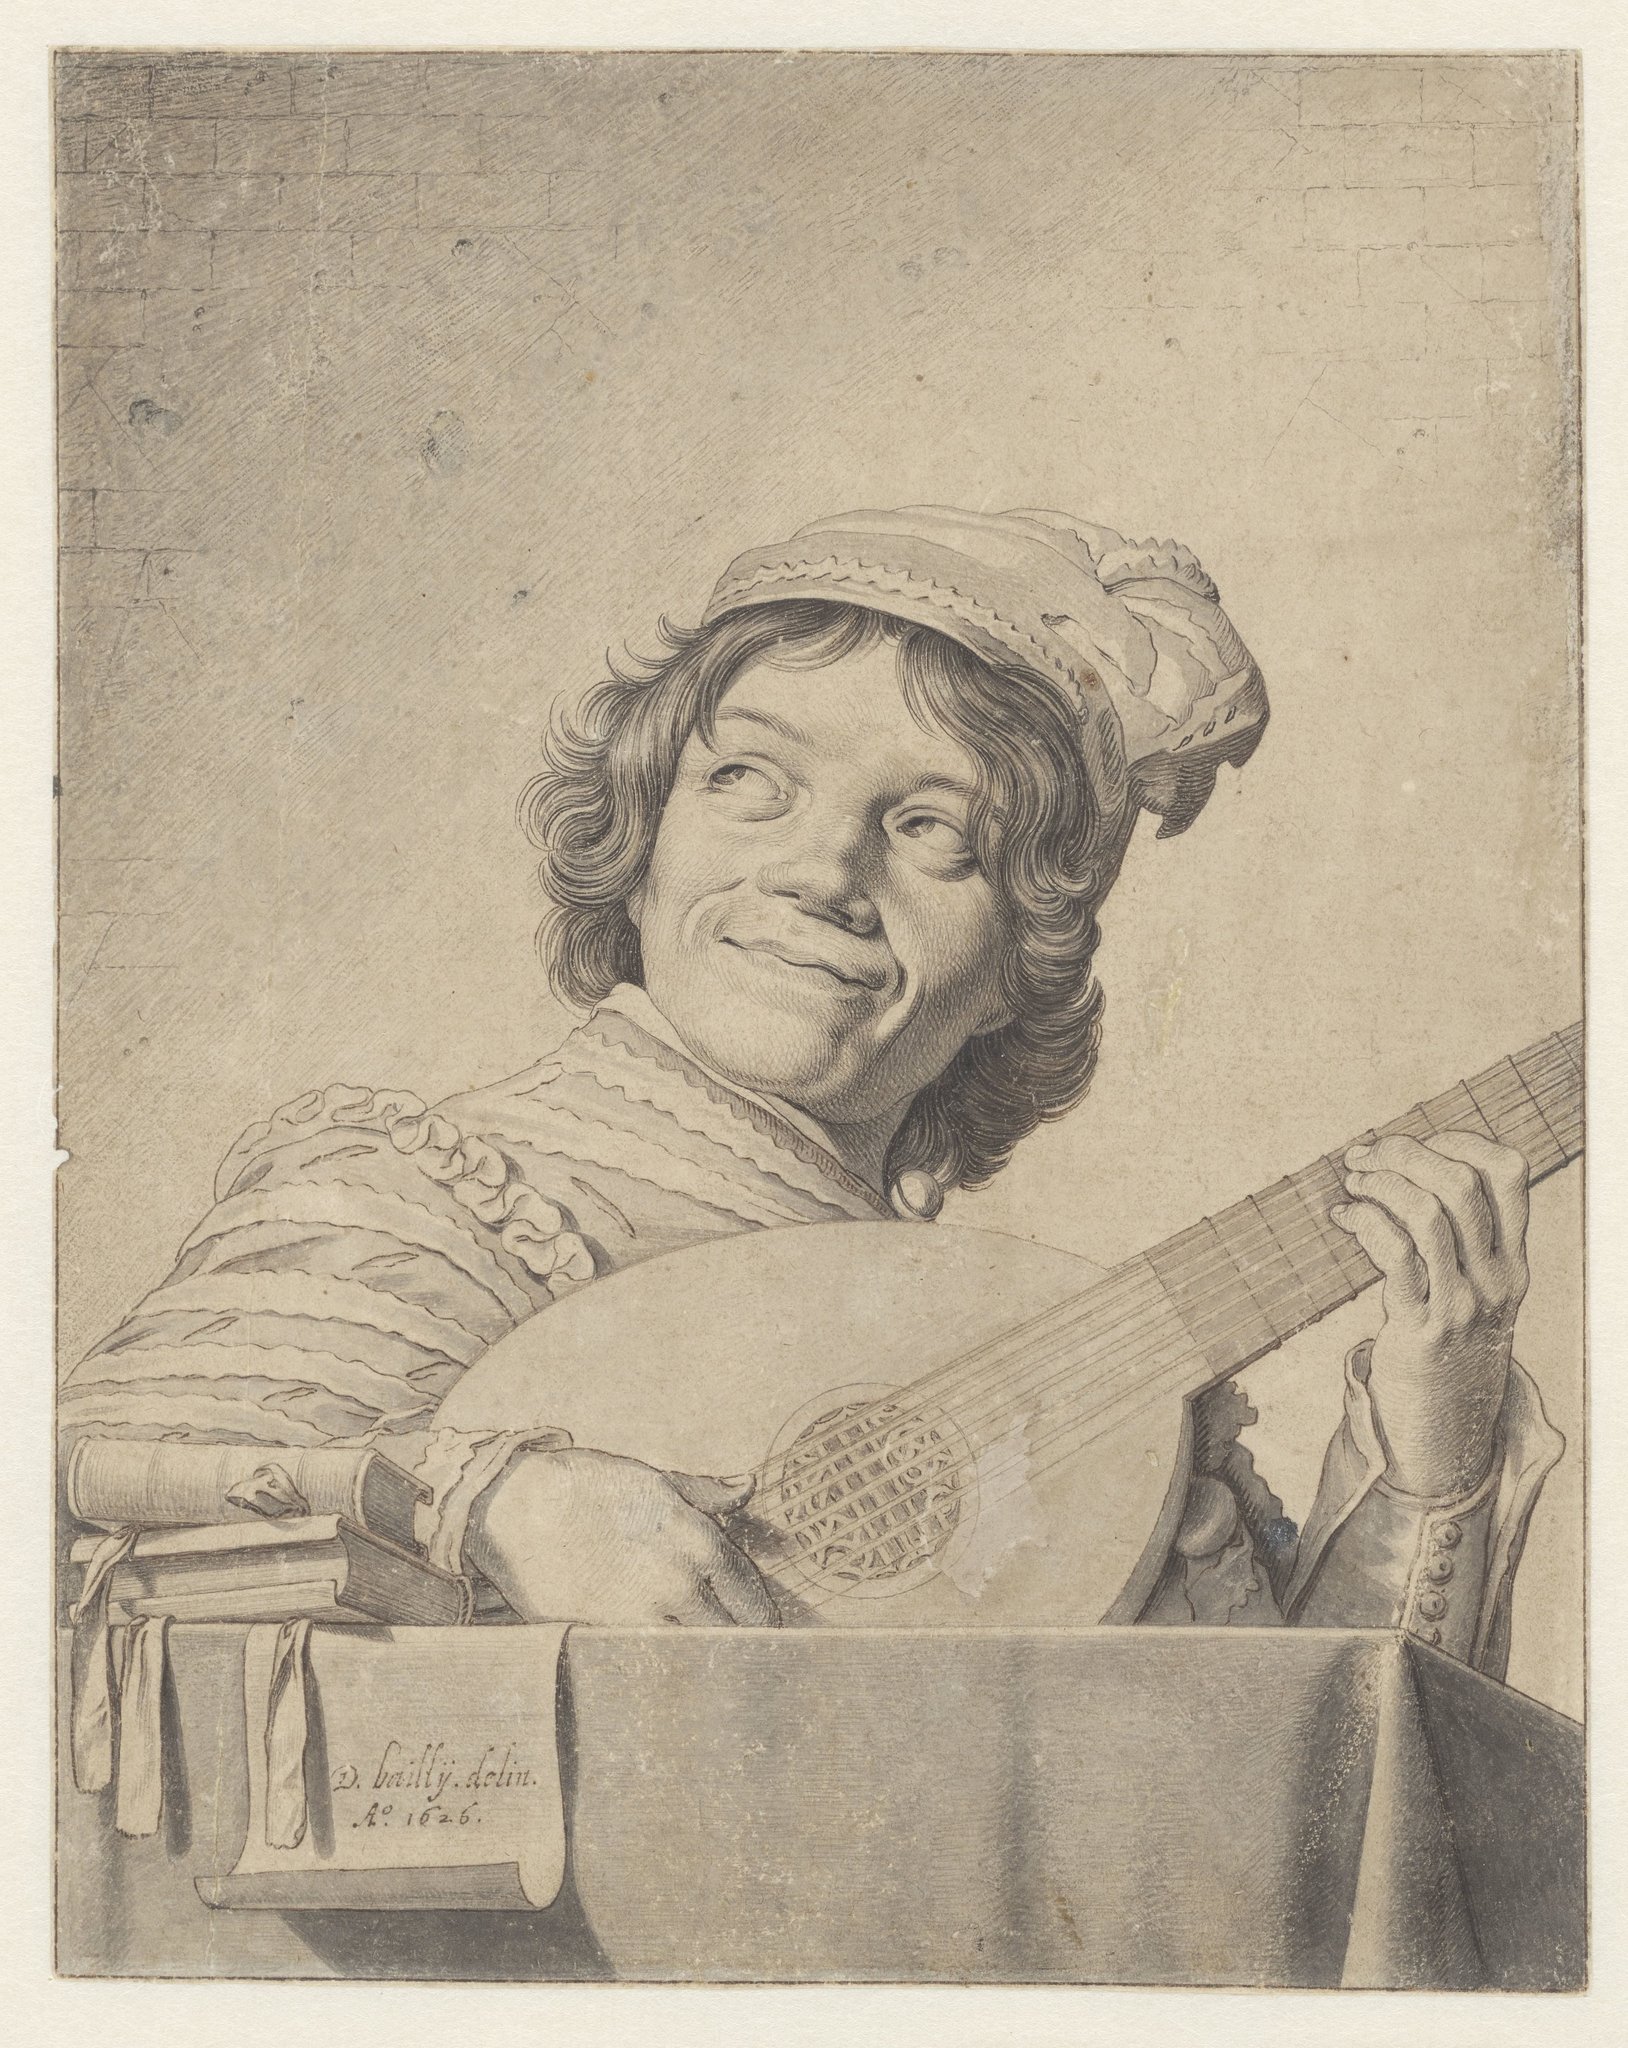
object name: drawing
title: De Luitspeler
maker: david bailly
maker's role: draughtsman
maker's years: 1584-1657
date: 1626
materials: ink, paper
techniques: brush, pen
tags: one person playing string instrument (plucked), lute, and special forms of lute, e.g.: theorbo